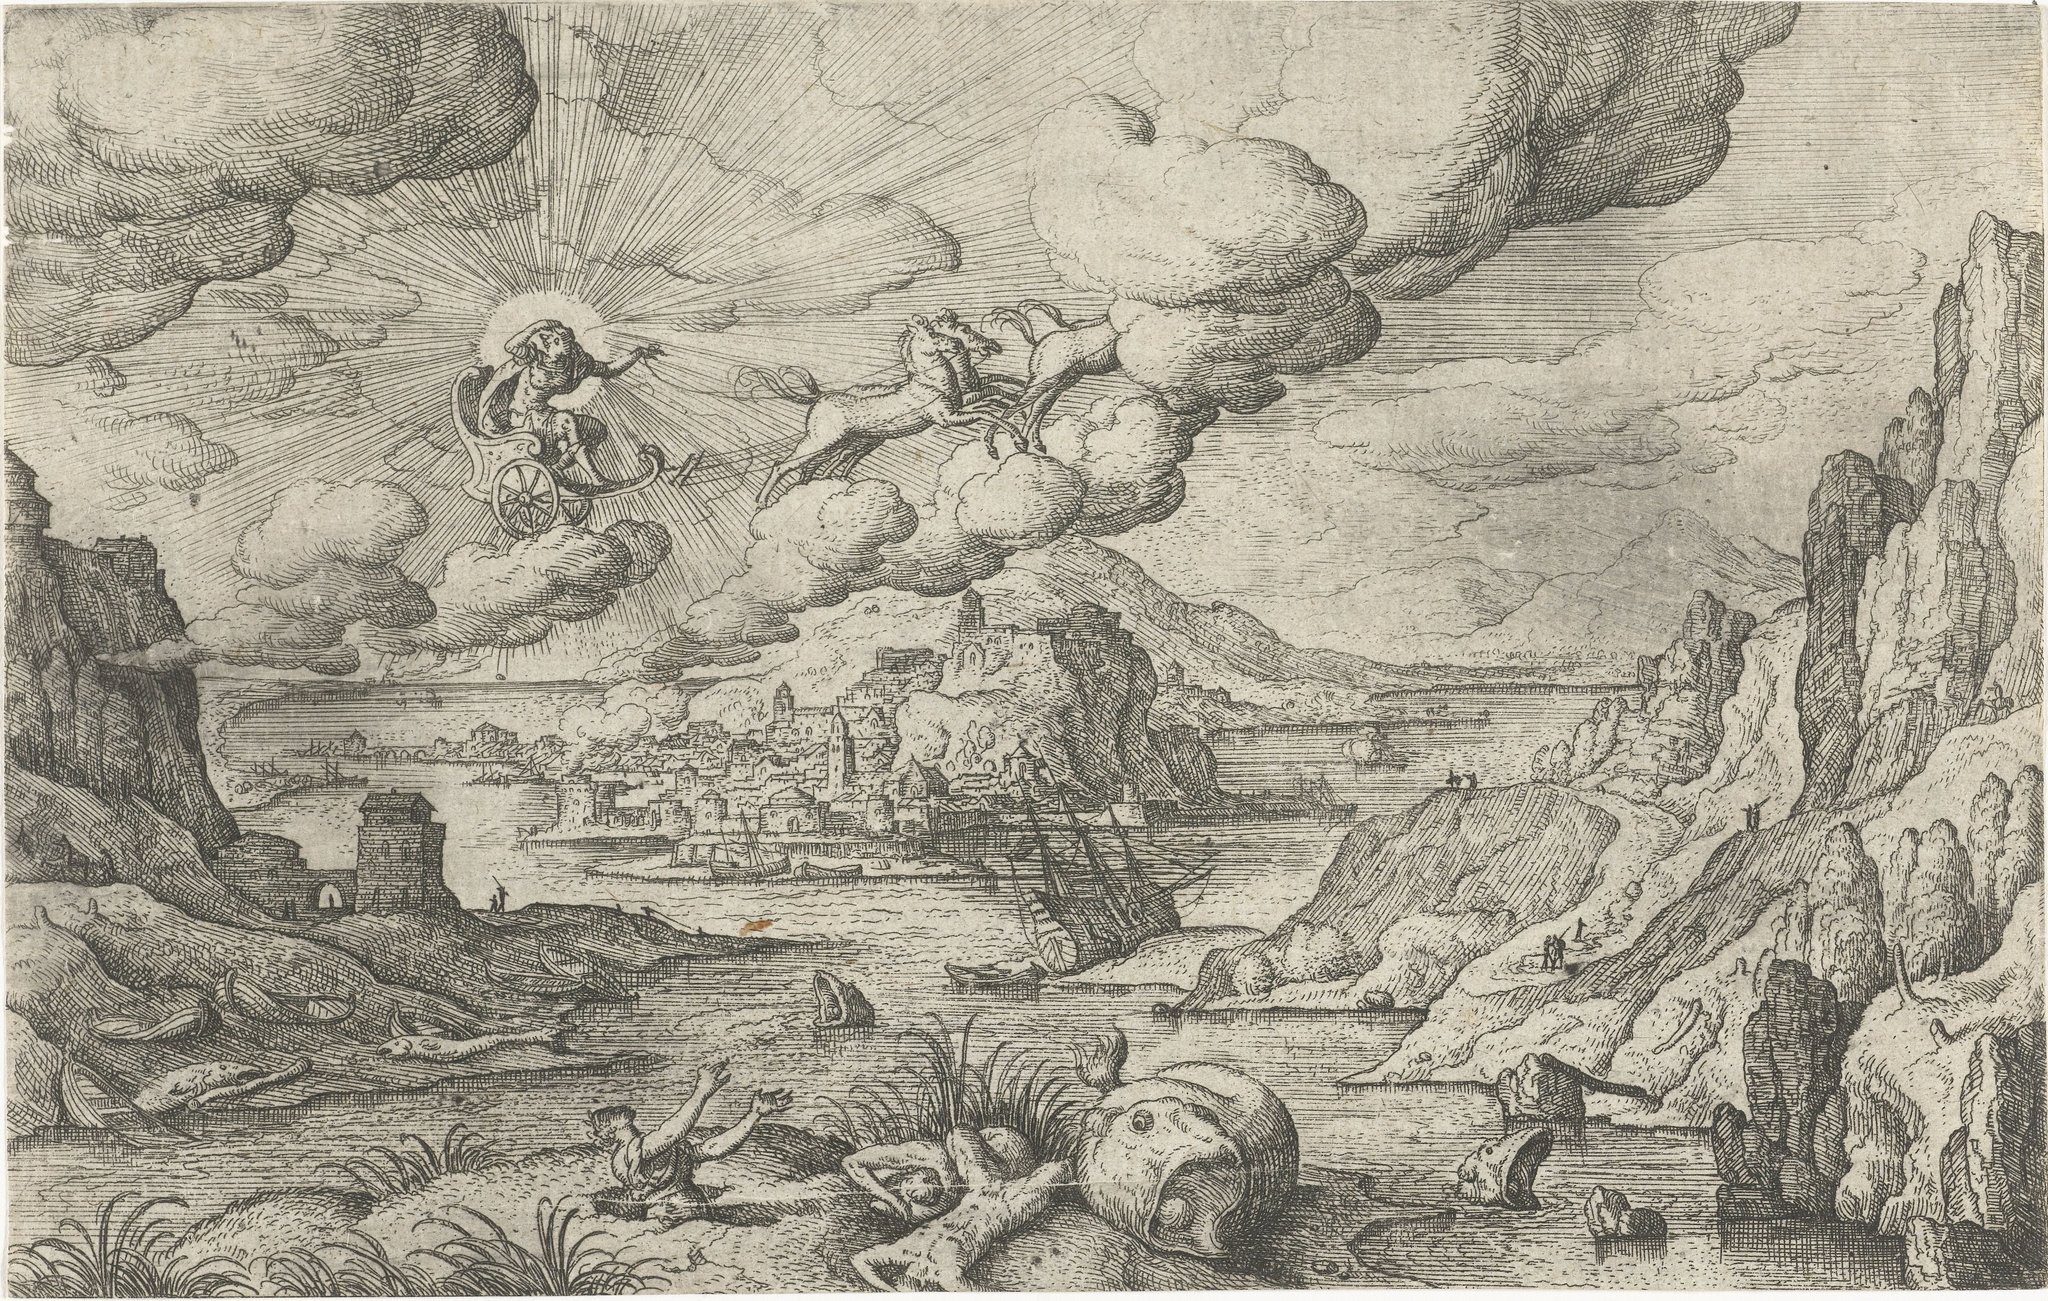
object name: print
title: Landschappen met mythologische en bijbelse voorstellingen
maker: Anonymous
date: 1550-1650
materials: paper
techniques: etching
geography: southern netherlands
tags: phaethon drives the chariot of the sun; the earth is threatened with conflagration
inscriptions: collector's mark: Lugt 2228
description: Phaëthon rijdt in de wagen van zijn vader de zonnegod Helios. Hij verliest de teugels en de paarden slaan op hol. Dit heeft zware gevolgen voor de aarde. Schepen lijden schipbreuk, dieren en mensen sterven